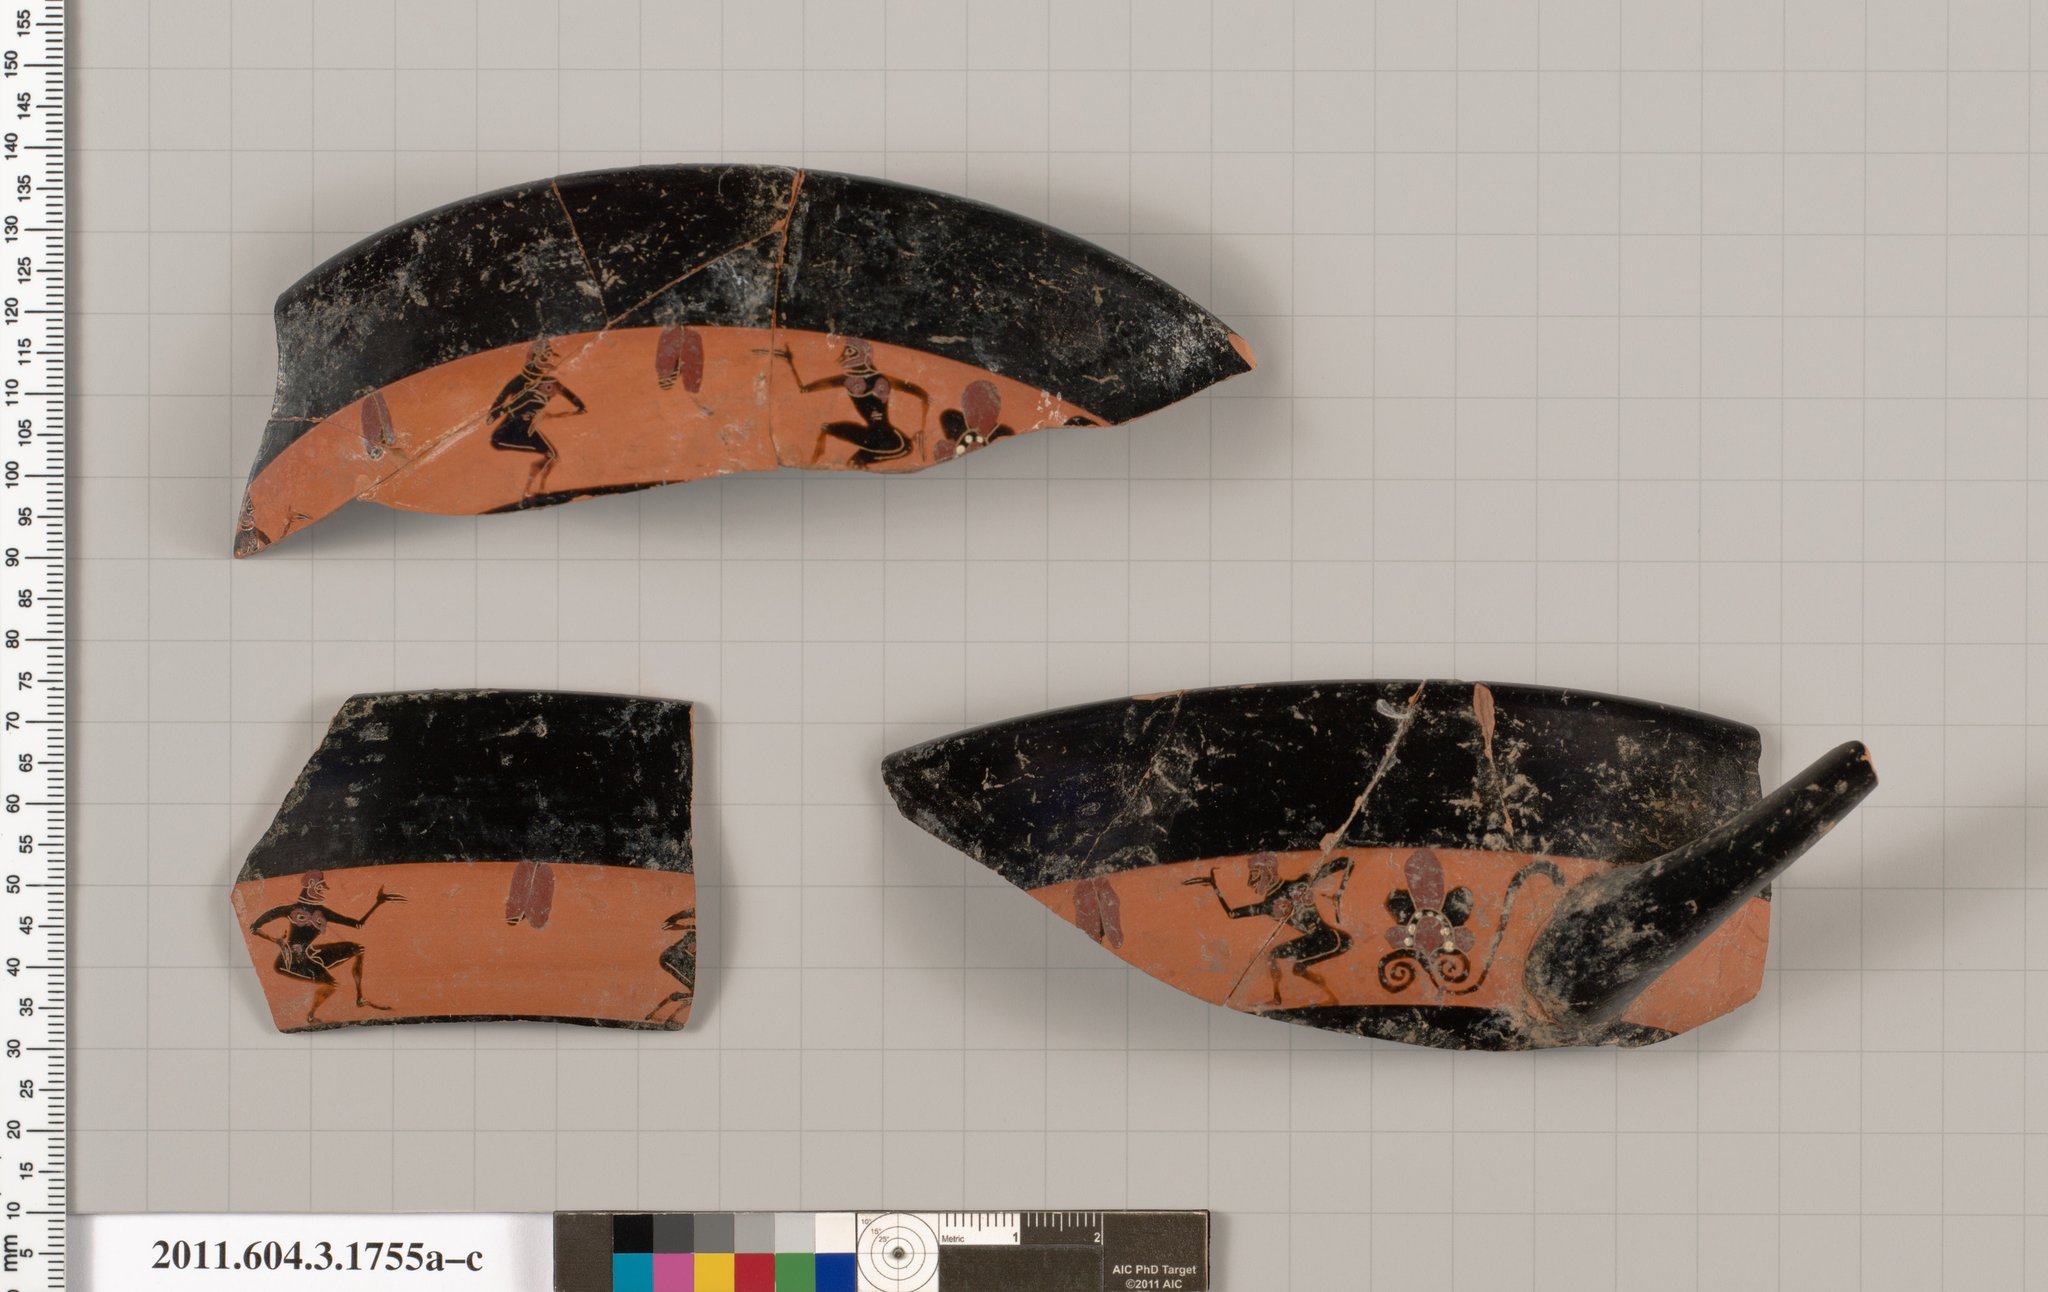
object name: kylix fragment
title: Terracotta fragments of a kylix: Band cup (drinking cup)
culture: greek, attic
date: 567-535 BCE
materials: terracotta